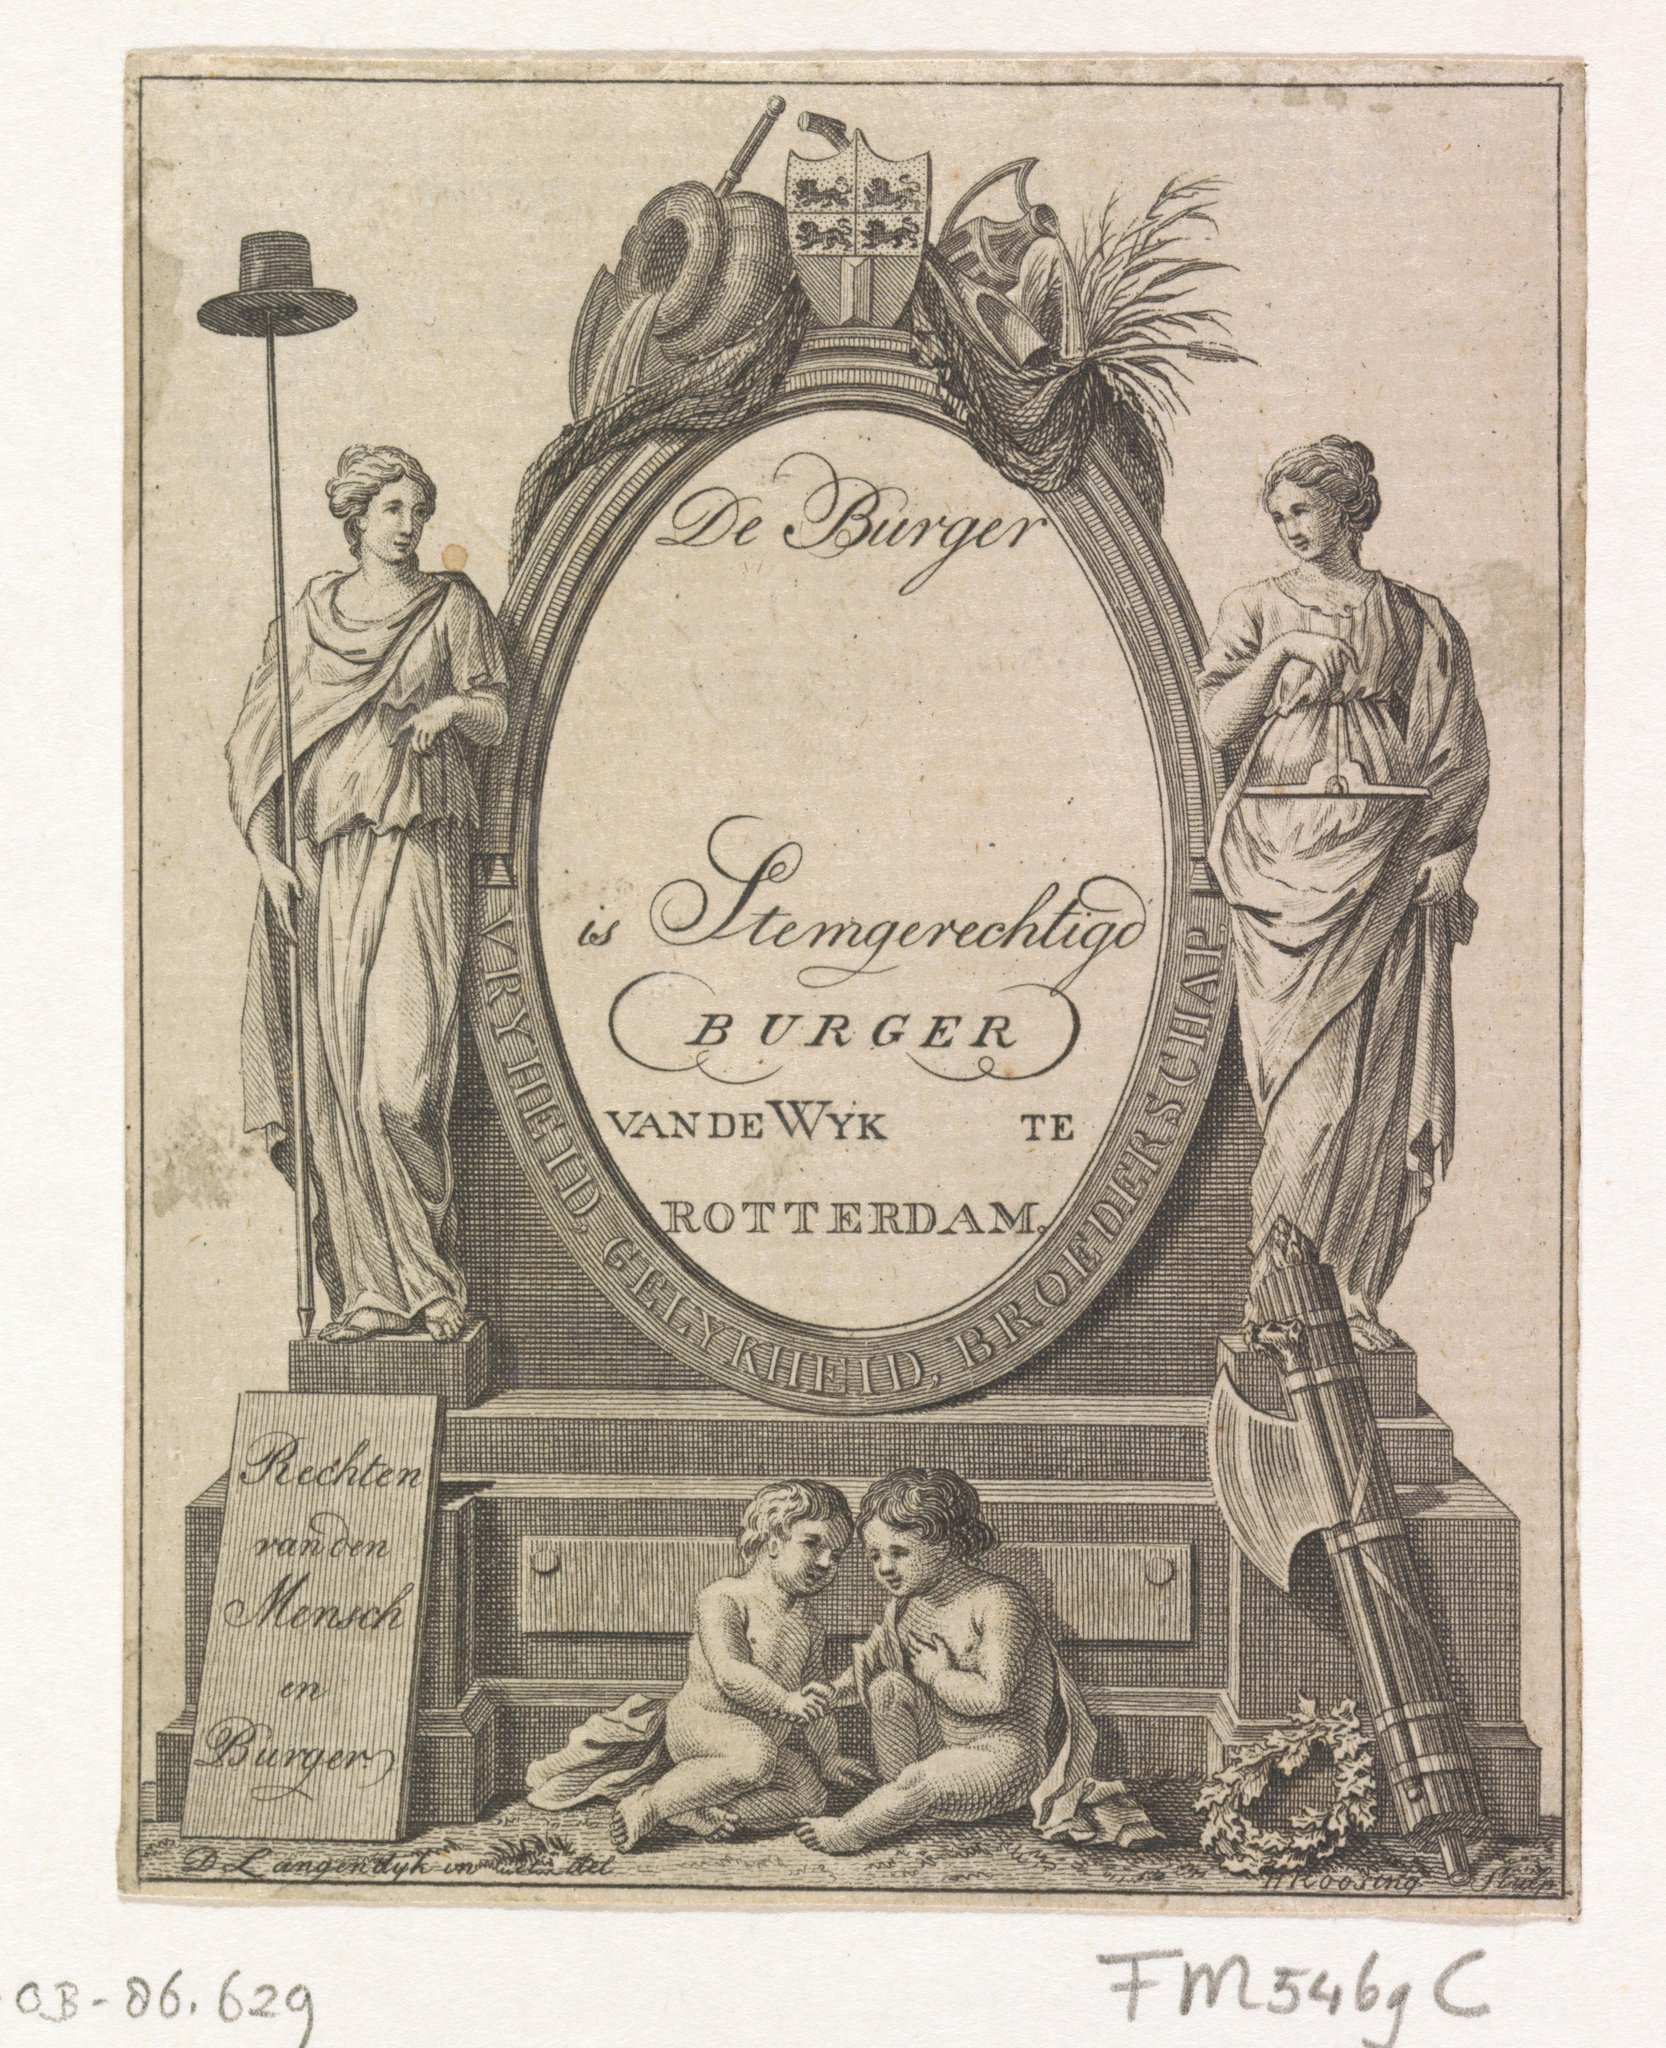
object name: print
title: Stembriefje voor een burger te Rotterdam, 1796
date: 1796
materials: paper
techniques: engraving, etching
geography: rotterdam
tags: equality, equity, fairness, righteousness; 'equalità', 'equità', 'giuditio giusto', 'ordine dritto e giusto', 'ugualità' (ripa) (+ abstract concept represented by female figure), brotherly love (+ two or more personifications pursuing one aim), freedom, liberty; 'libertà' (ripa) (+ abstract concept represented by female figure), rotterdam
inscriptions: collector's mark: Lugt 2228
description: Stembriefje voor een burger te Rotterdam, 1796. Cartouche waarin de naam van de stemgerechtigde en het nummer van de wijk ingevuld kunnen worden. Aan weerszijden van de cartouche staande figuren van Vrijheid en Gelijkheid, onderaan twee kinderen als Broederschap. Met tekst en datum op de achterzijde.